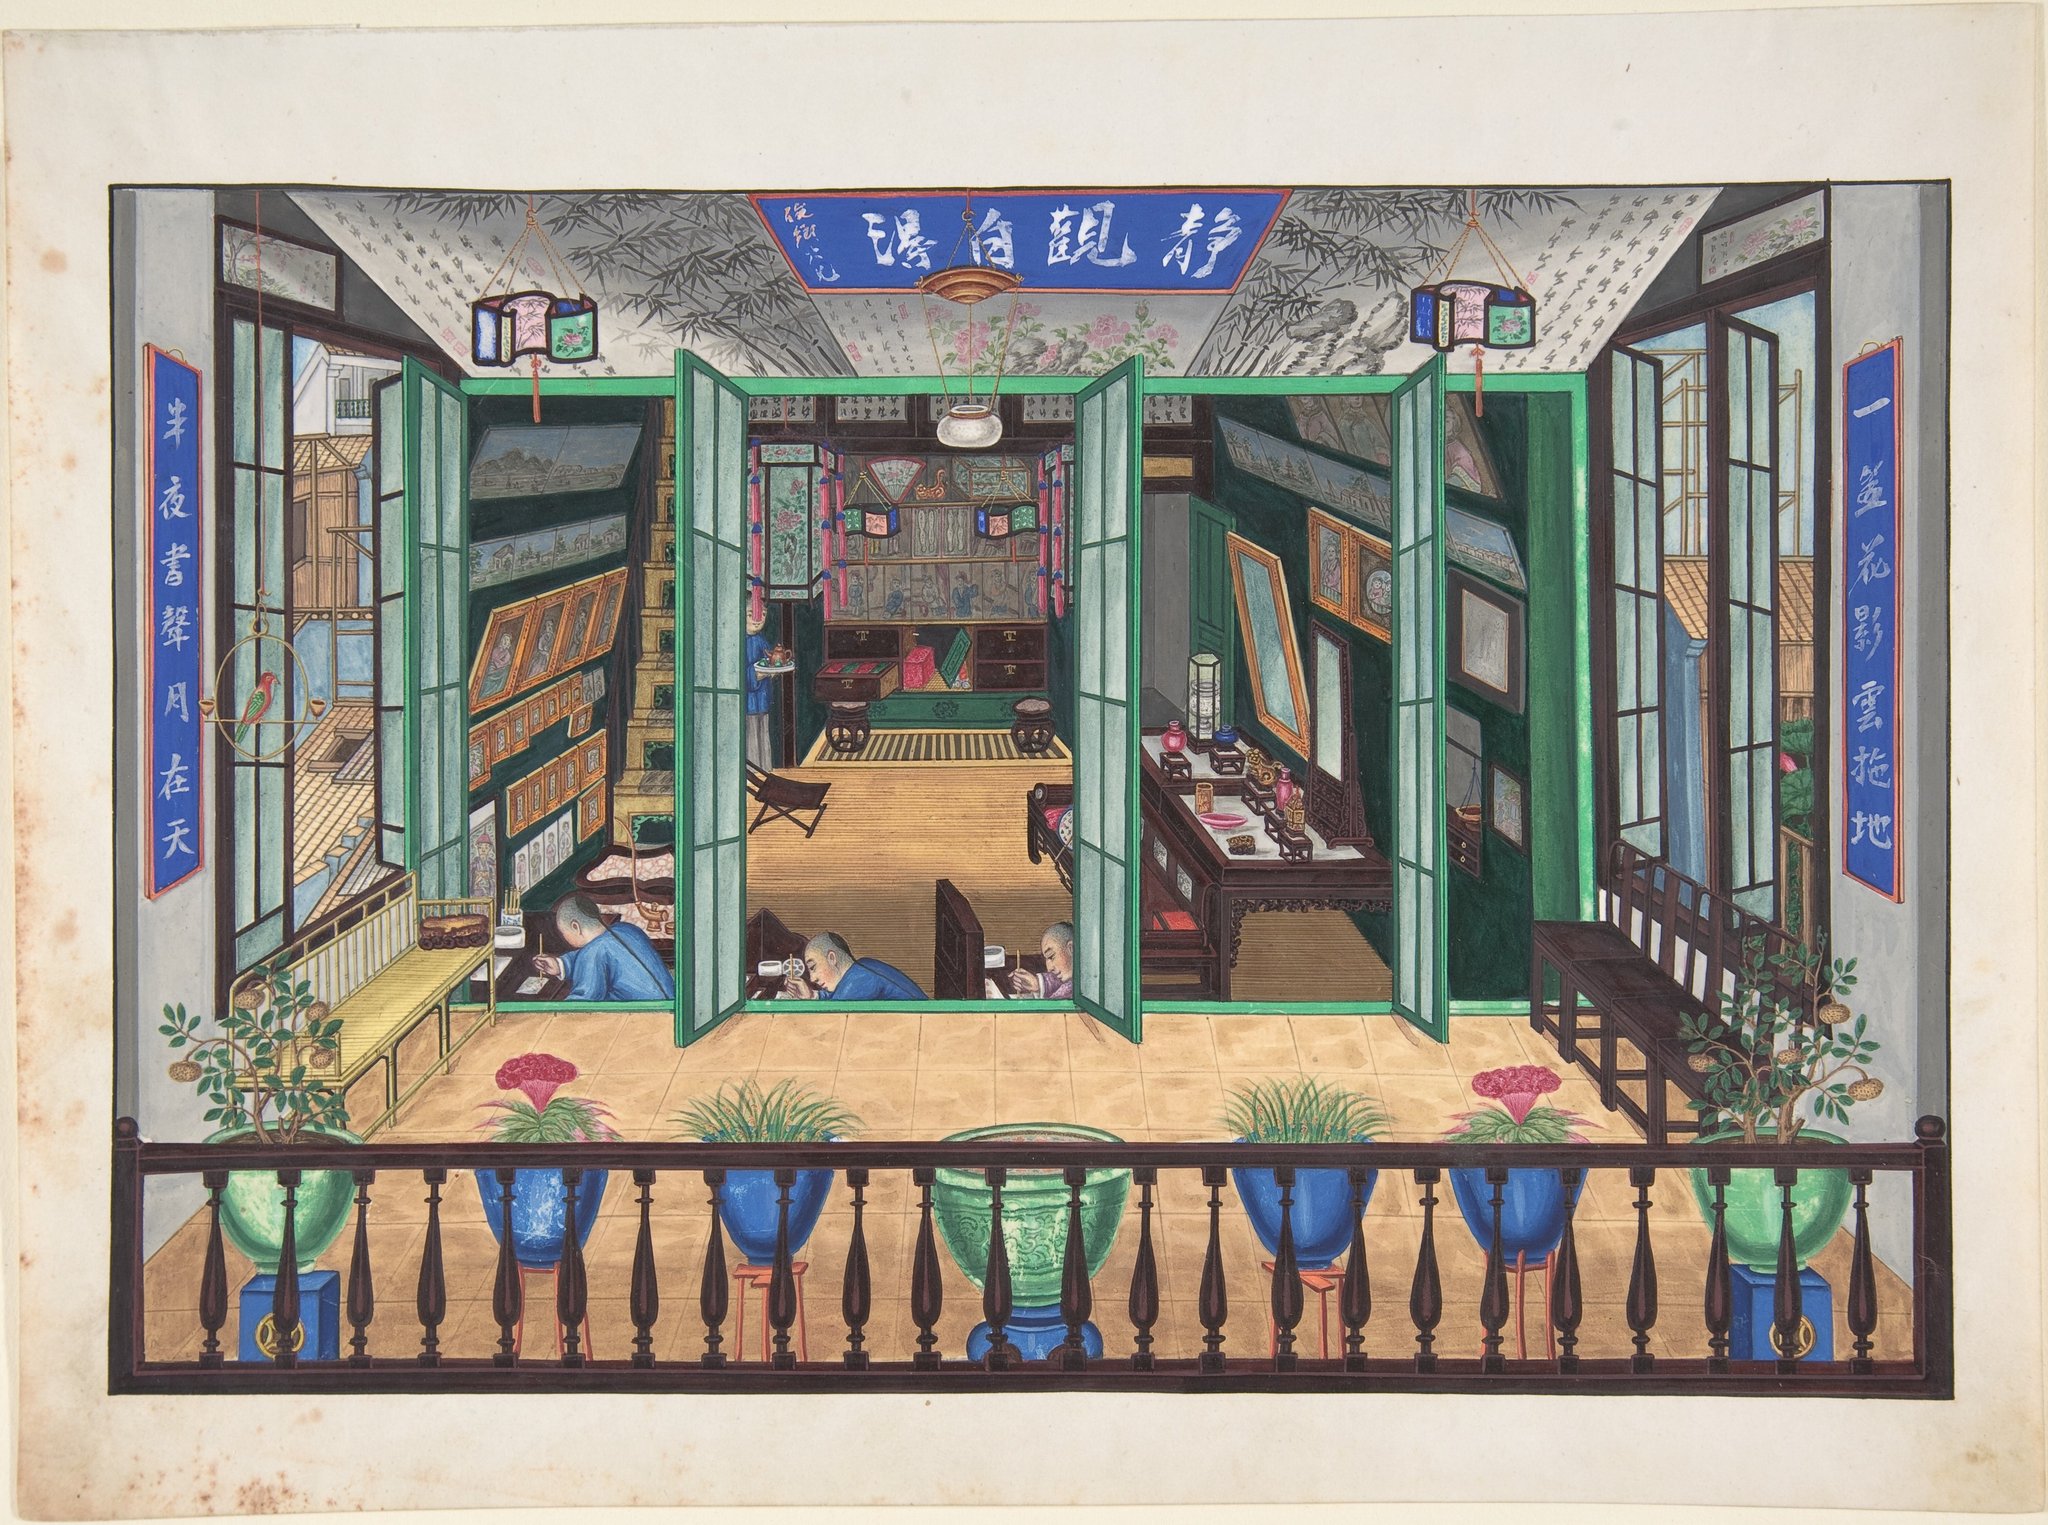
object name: drawing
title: Hall of Quiet Study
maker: anonymous, chinese, canton, 19th century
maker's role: artist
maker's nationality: chinese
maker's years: 1800-1900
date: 1801-1900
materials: watercolor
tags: painting,interiors,tables